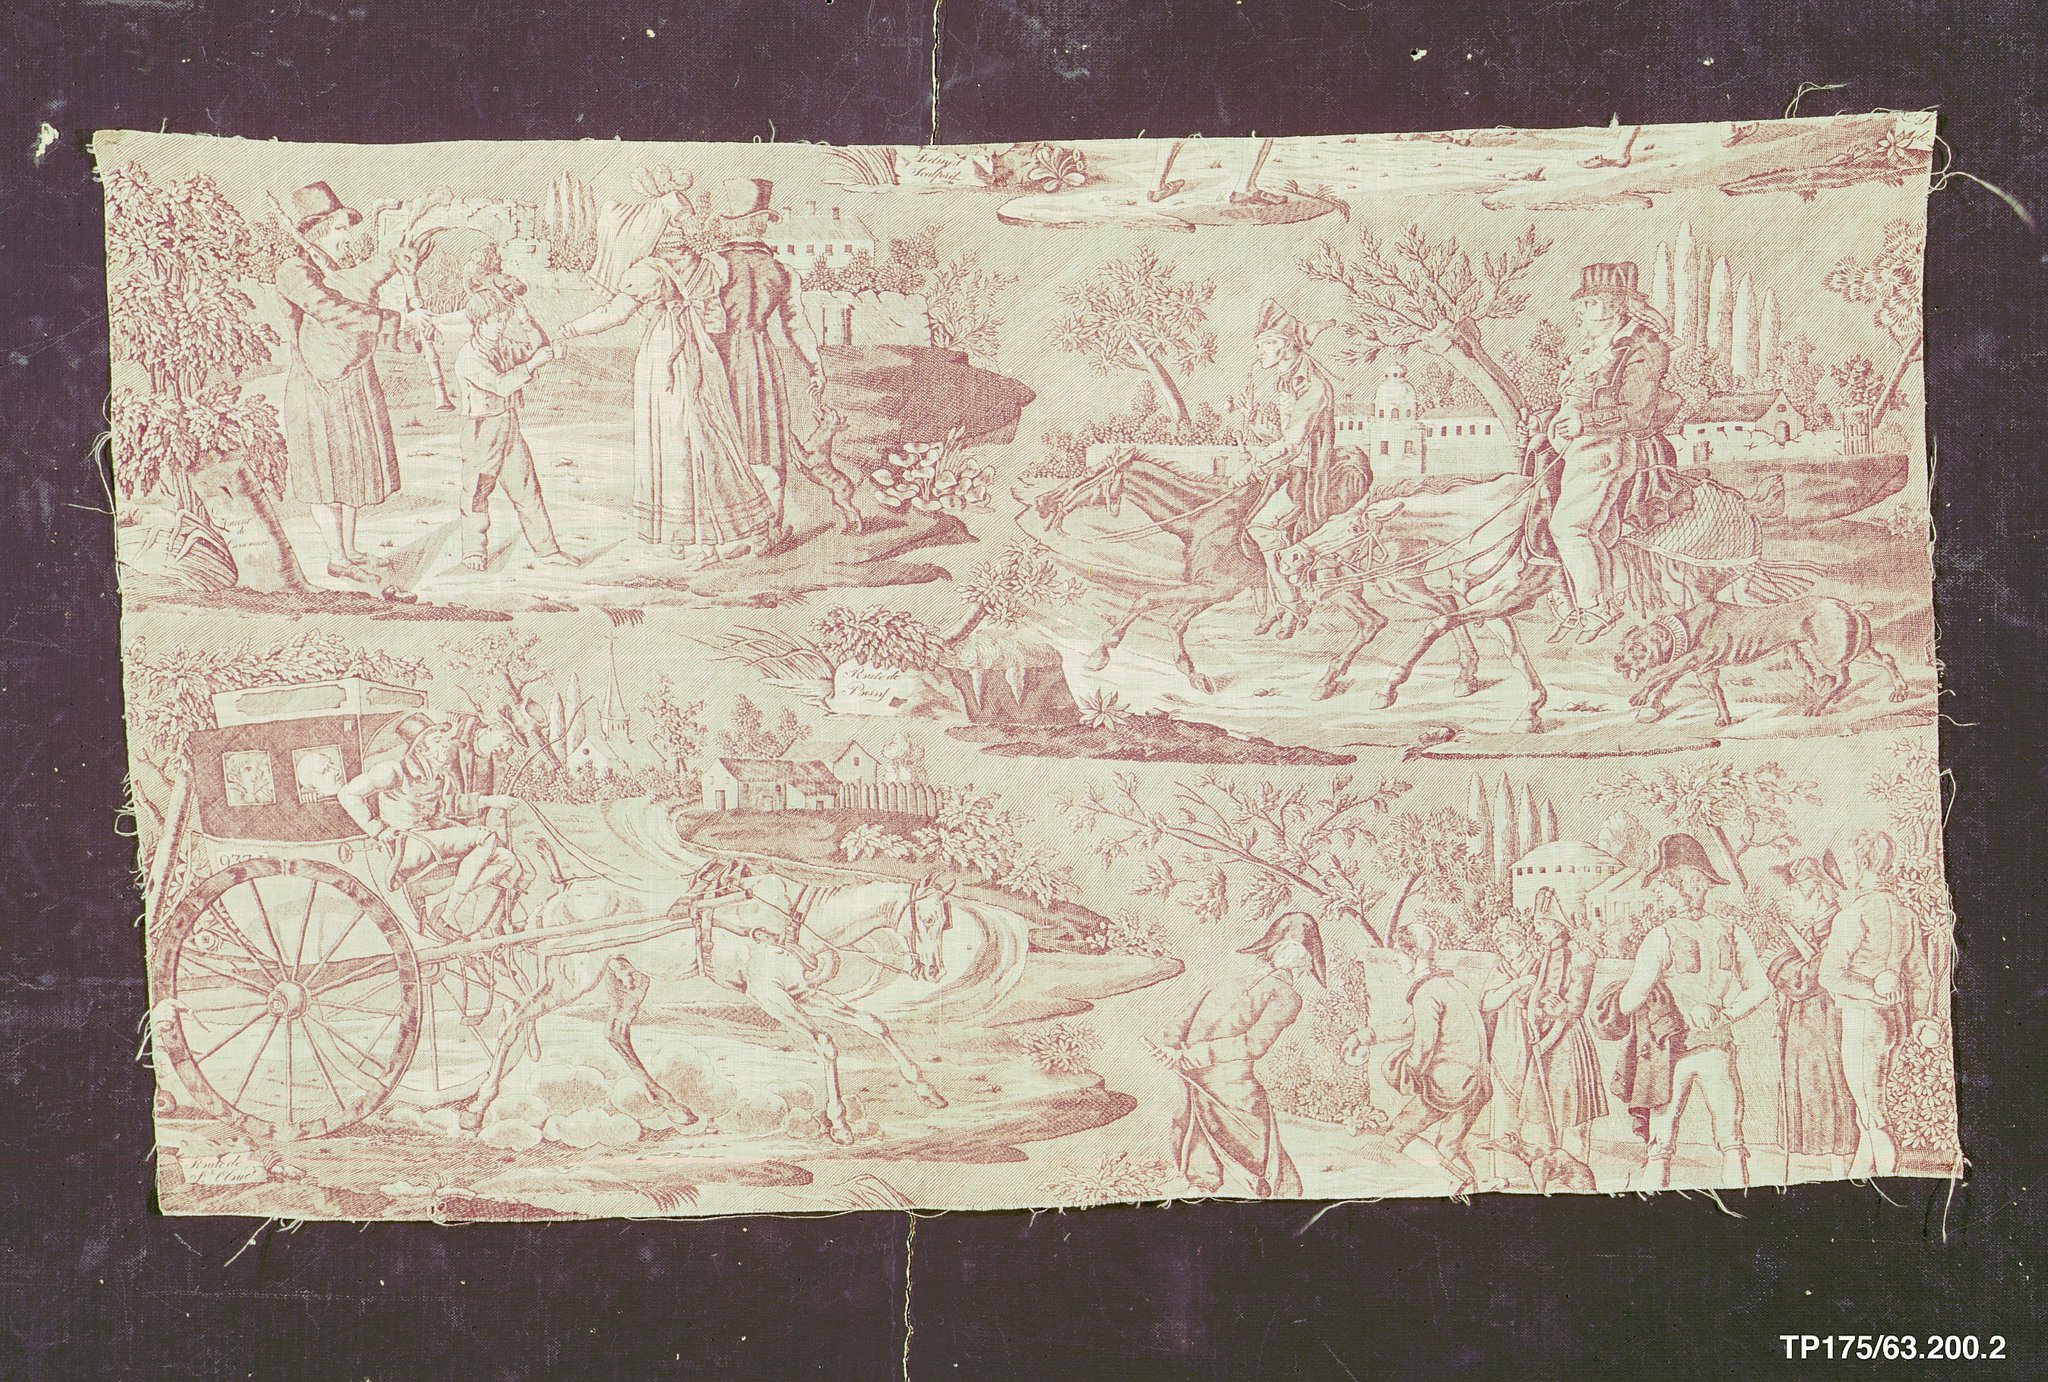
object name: piece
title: "La Route de Poissy" with other scenes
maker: ferdinand favre et cie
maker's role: manufactory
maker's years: 1818-1866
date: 1820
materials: cotton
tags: men,women,bagpipes,dogs,horses,carriages